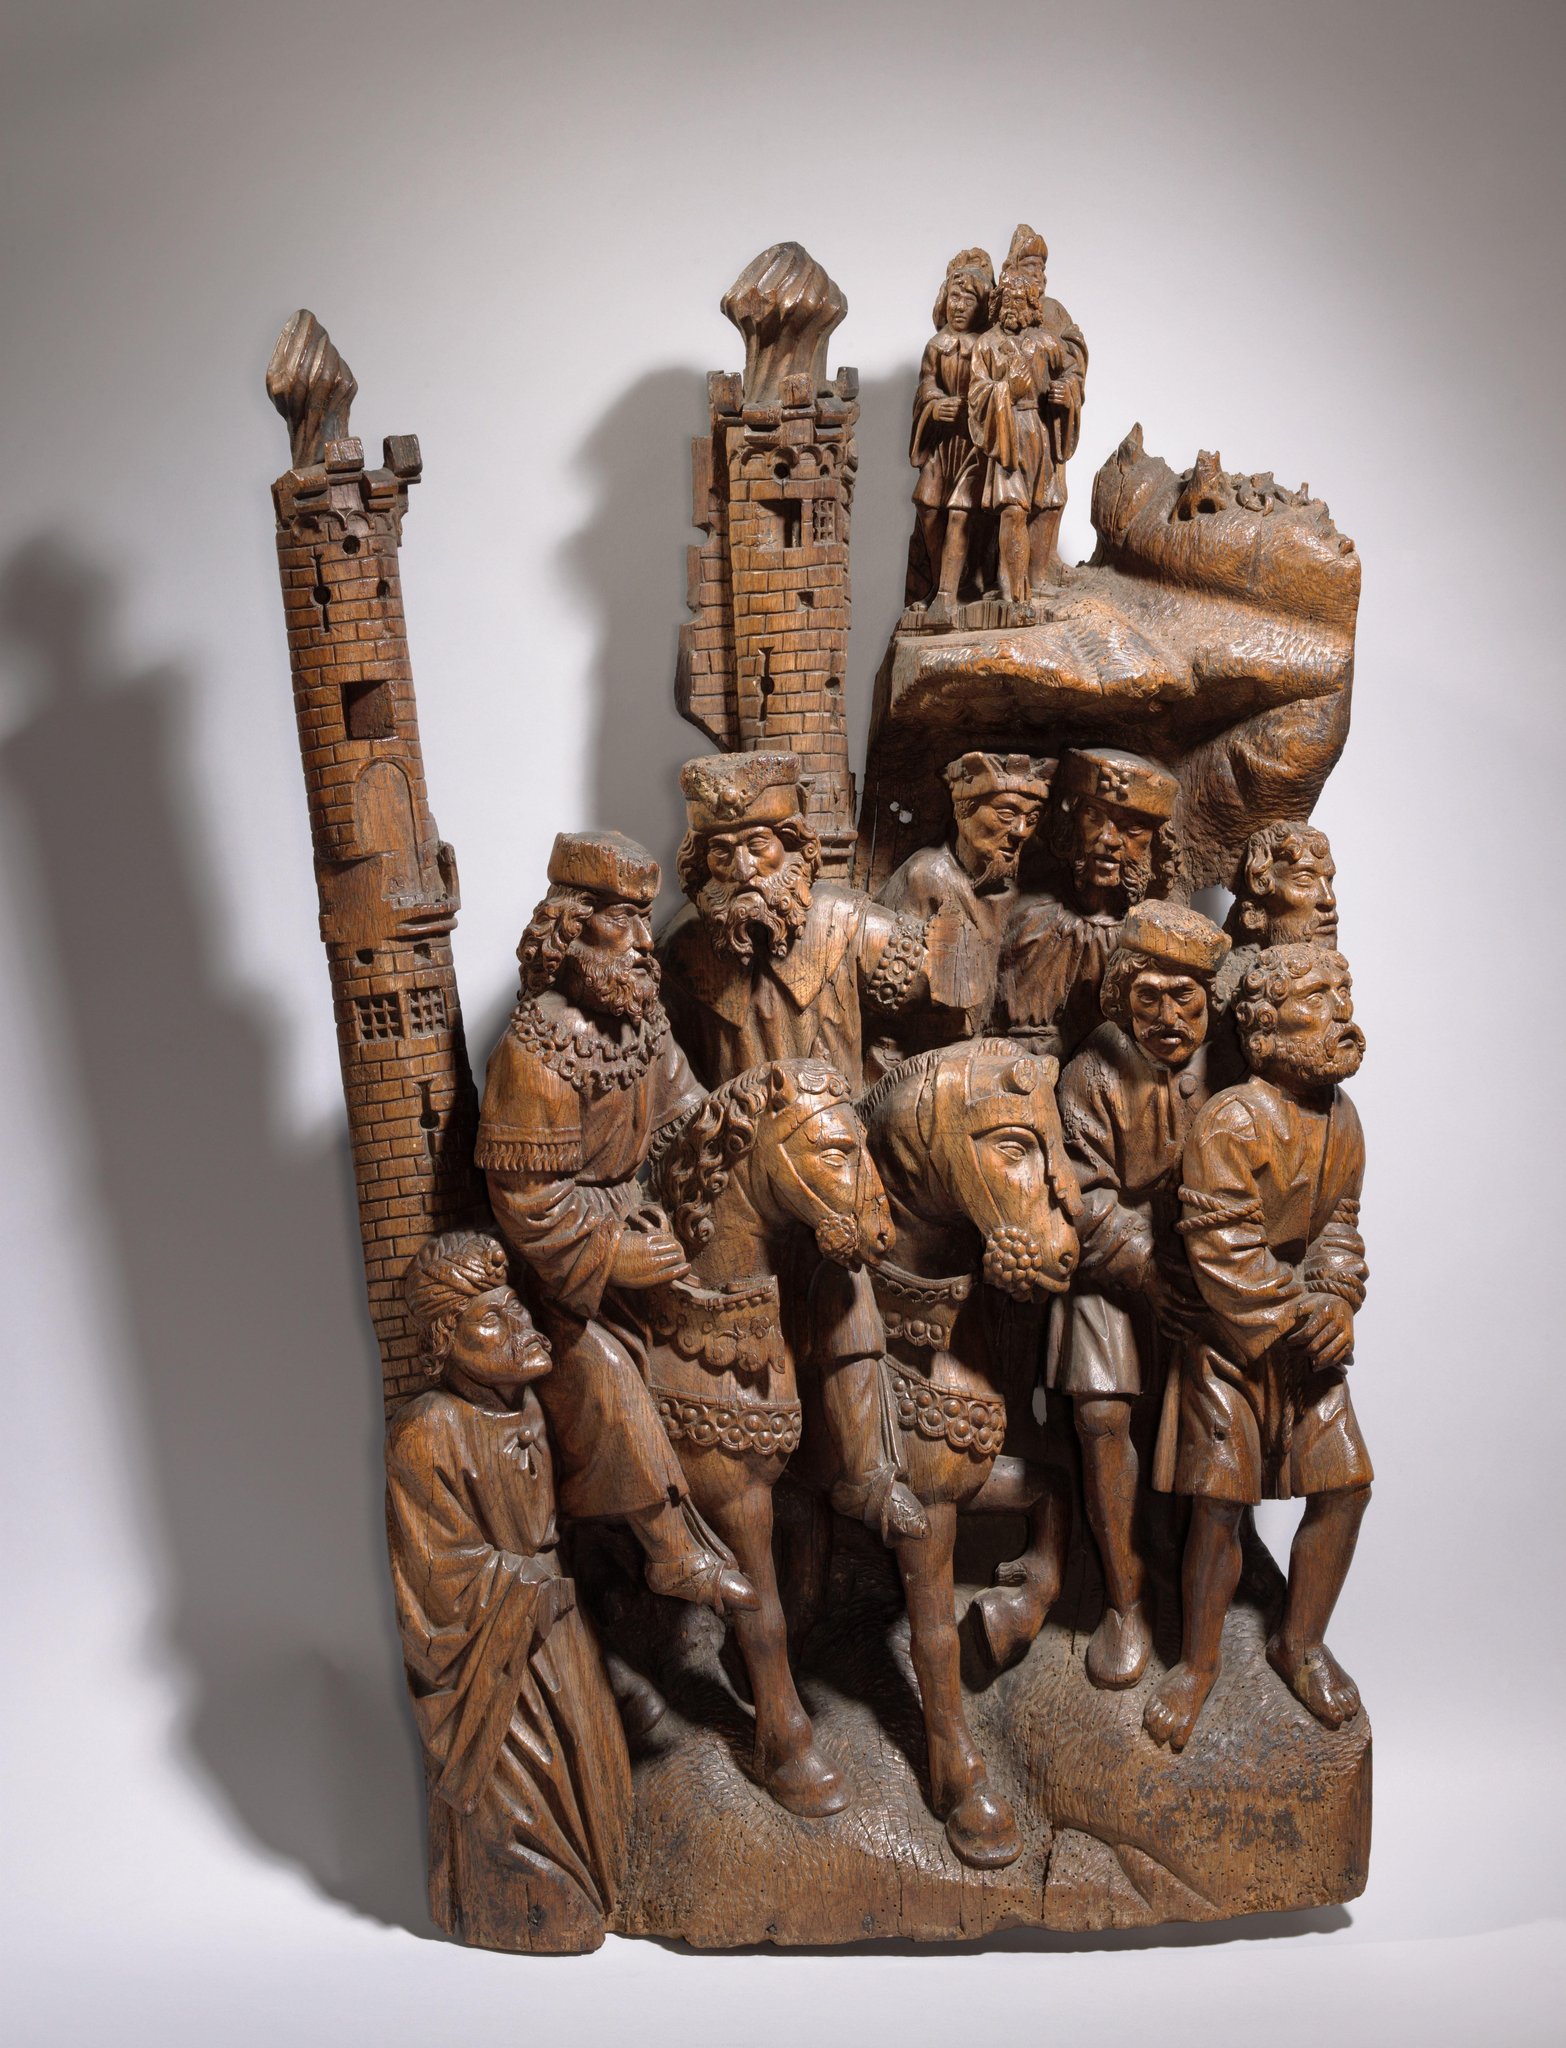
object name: sculpture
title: Procession of Men on Foot and Horseback, from a Christ Carrying the Cross Procession of Men on Foot and Horseback, from a Christ Carrying the Cross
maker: master of st anthony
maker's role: sculptor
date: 1500-1520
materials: wood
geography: cleves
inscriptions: location mark, on the reverse, chiselled out: ‘^’, inscription, on the reverse, in red paint: ‘KOG C98’